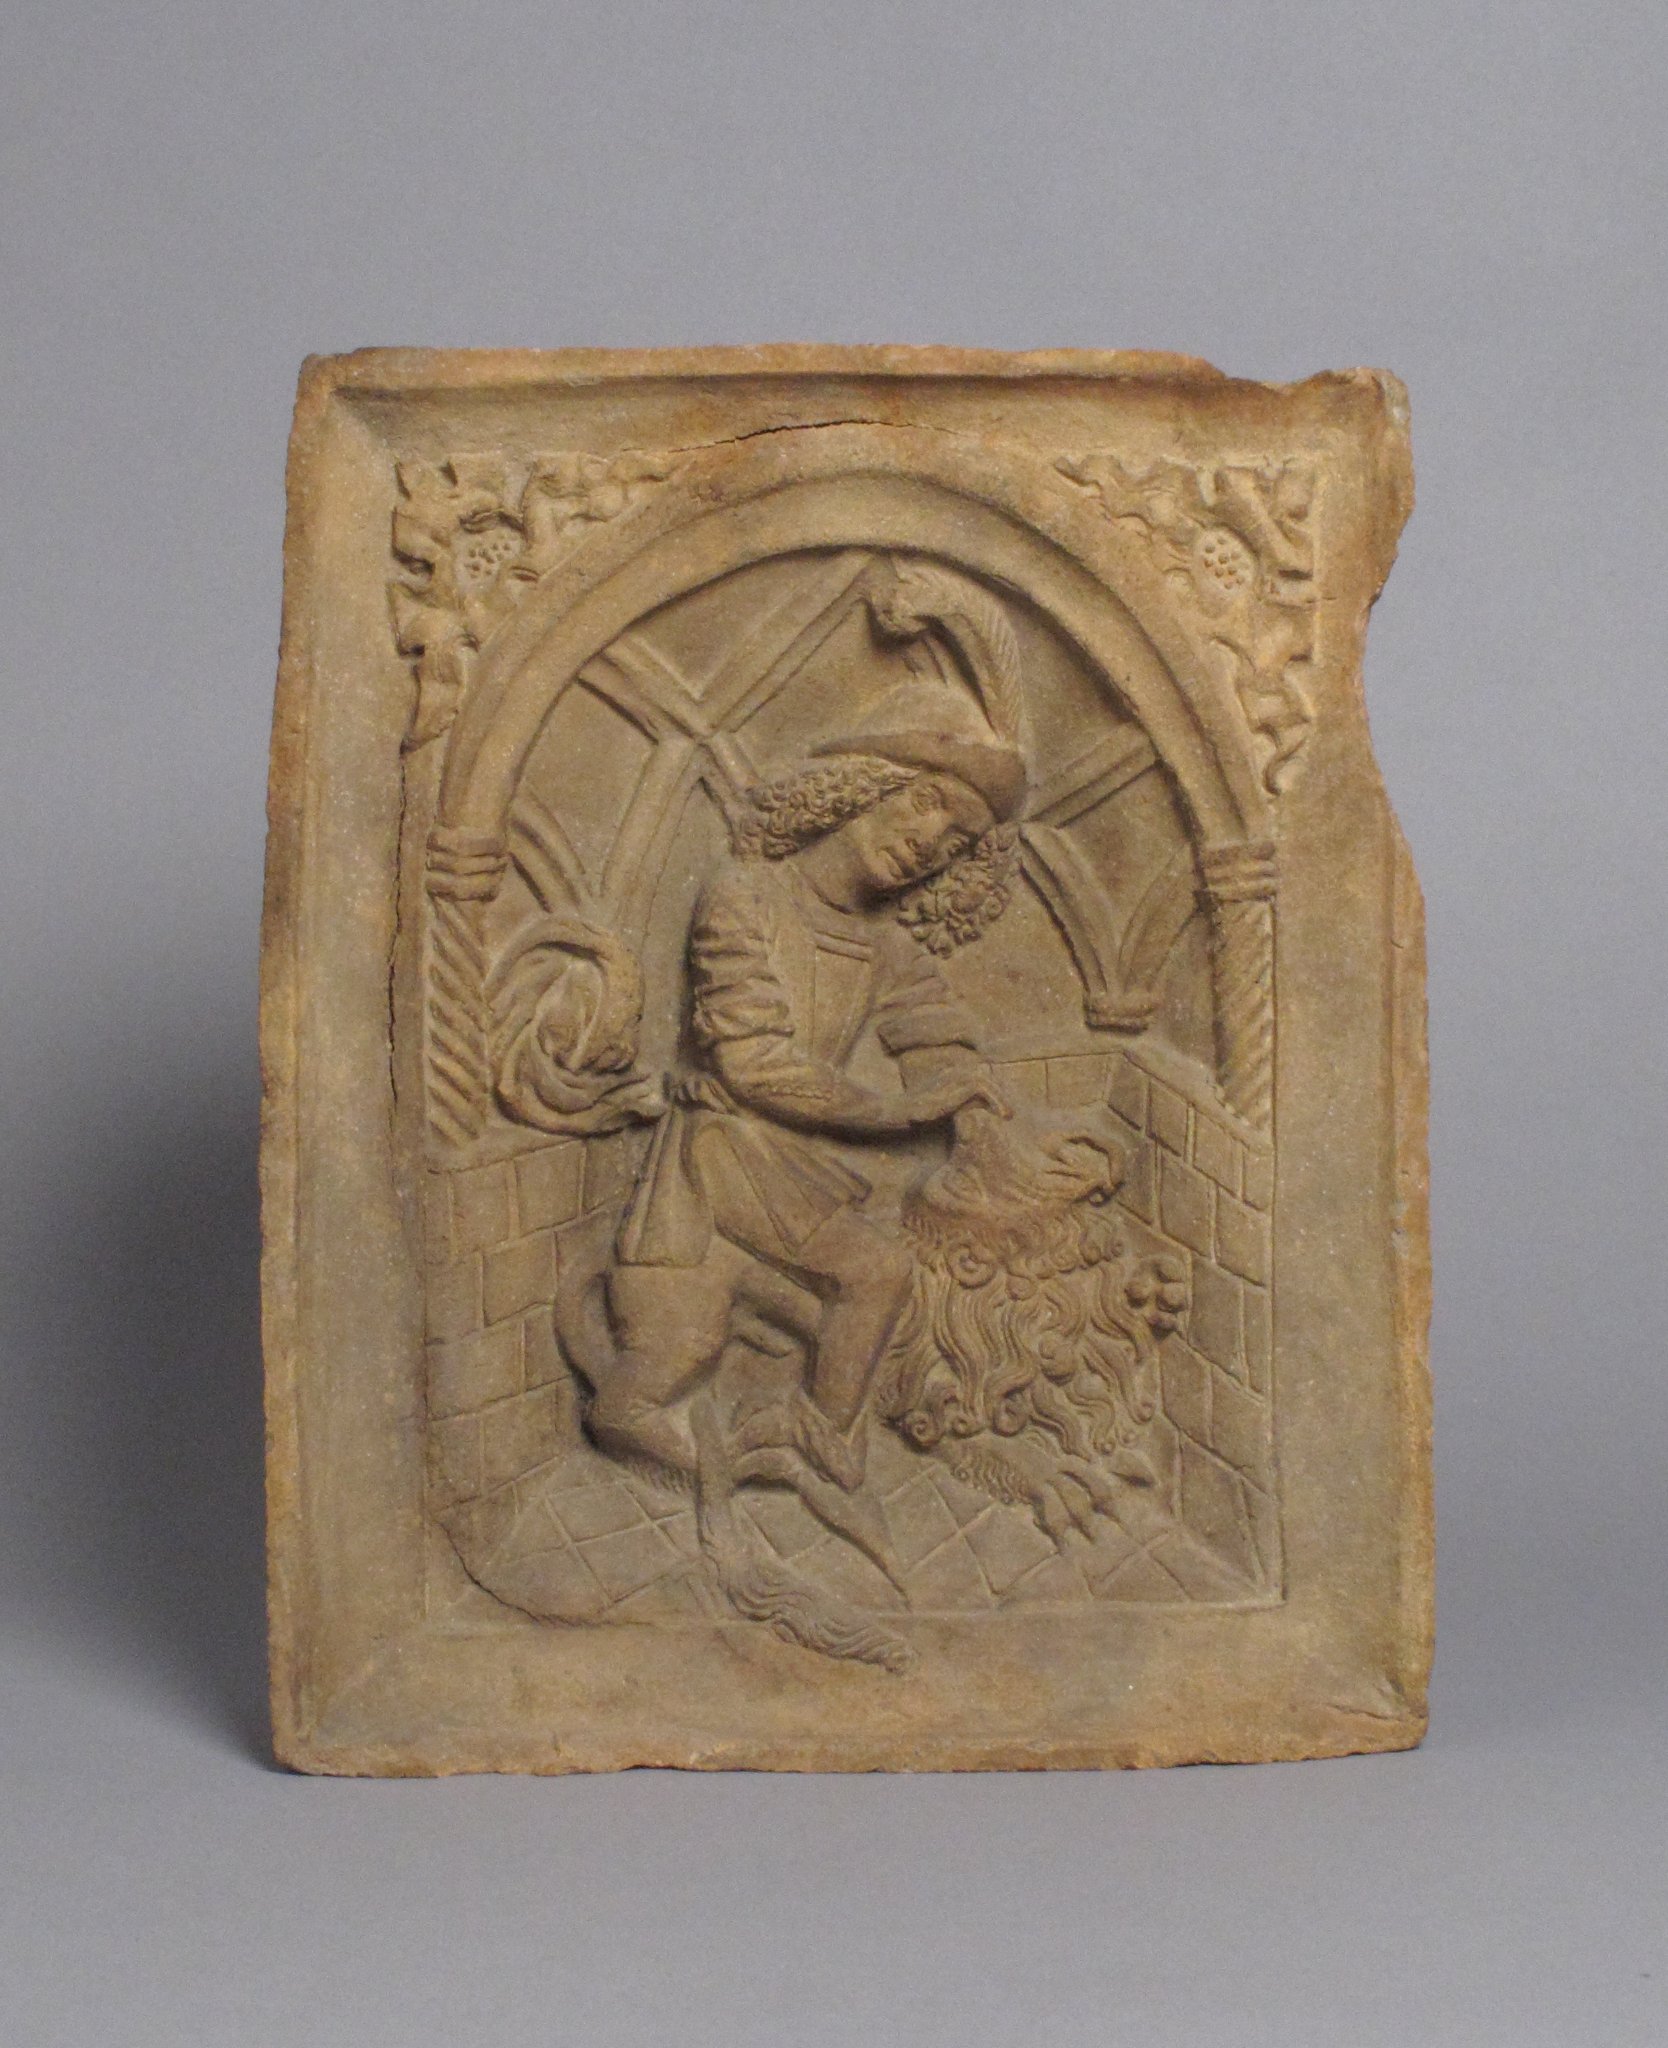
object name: tile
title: Oven Tile with Samson and the Lion (Based on an Engraving by Master E.S.)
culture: austrian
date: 1490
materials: earthenware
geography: austria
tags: lions,samson